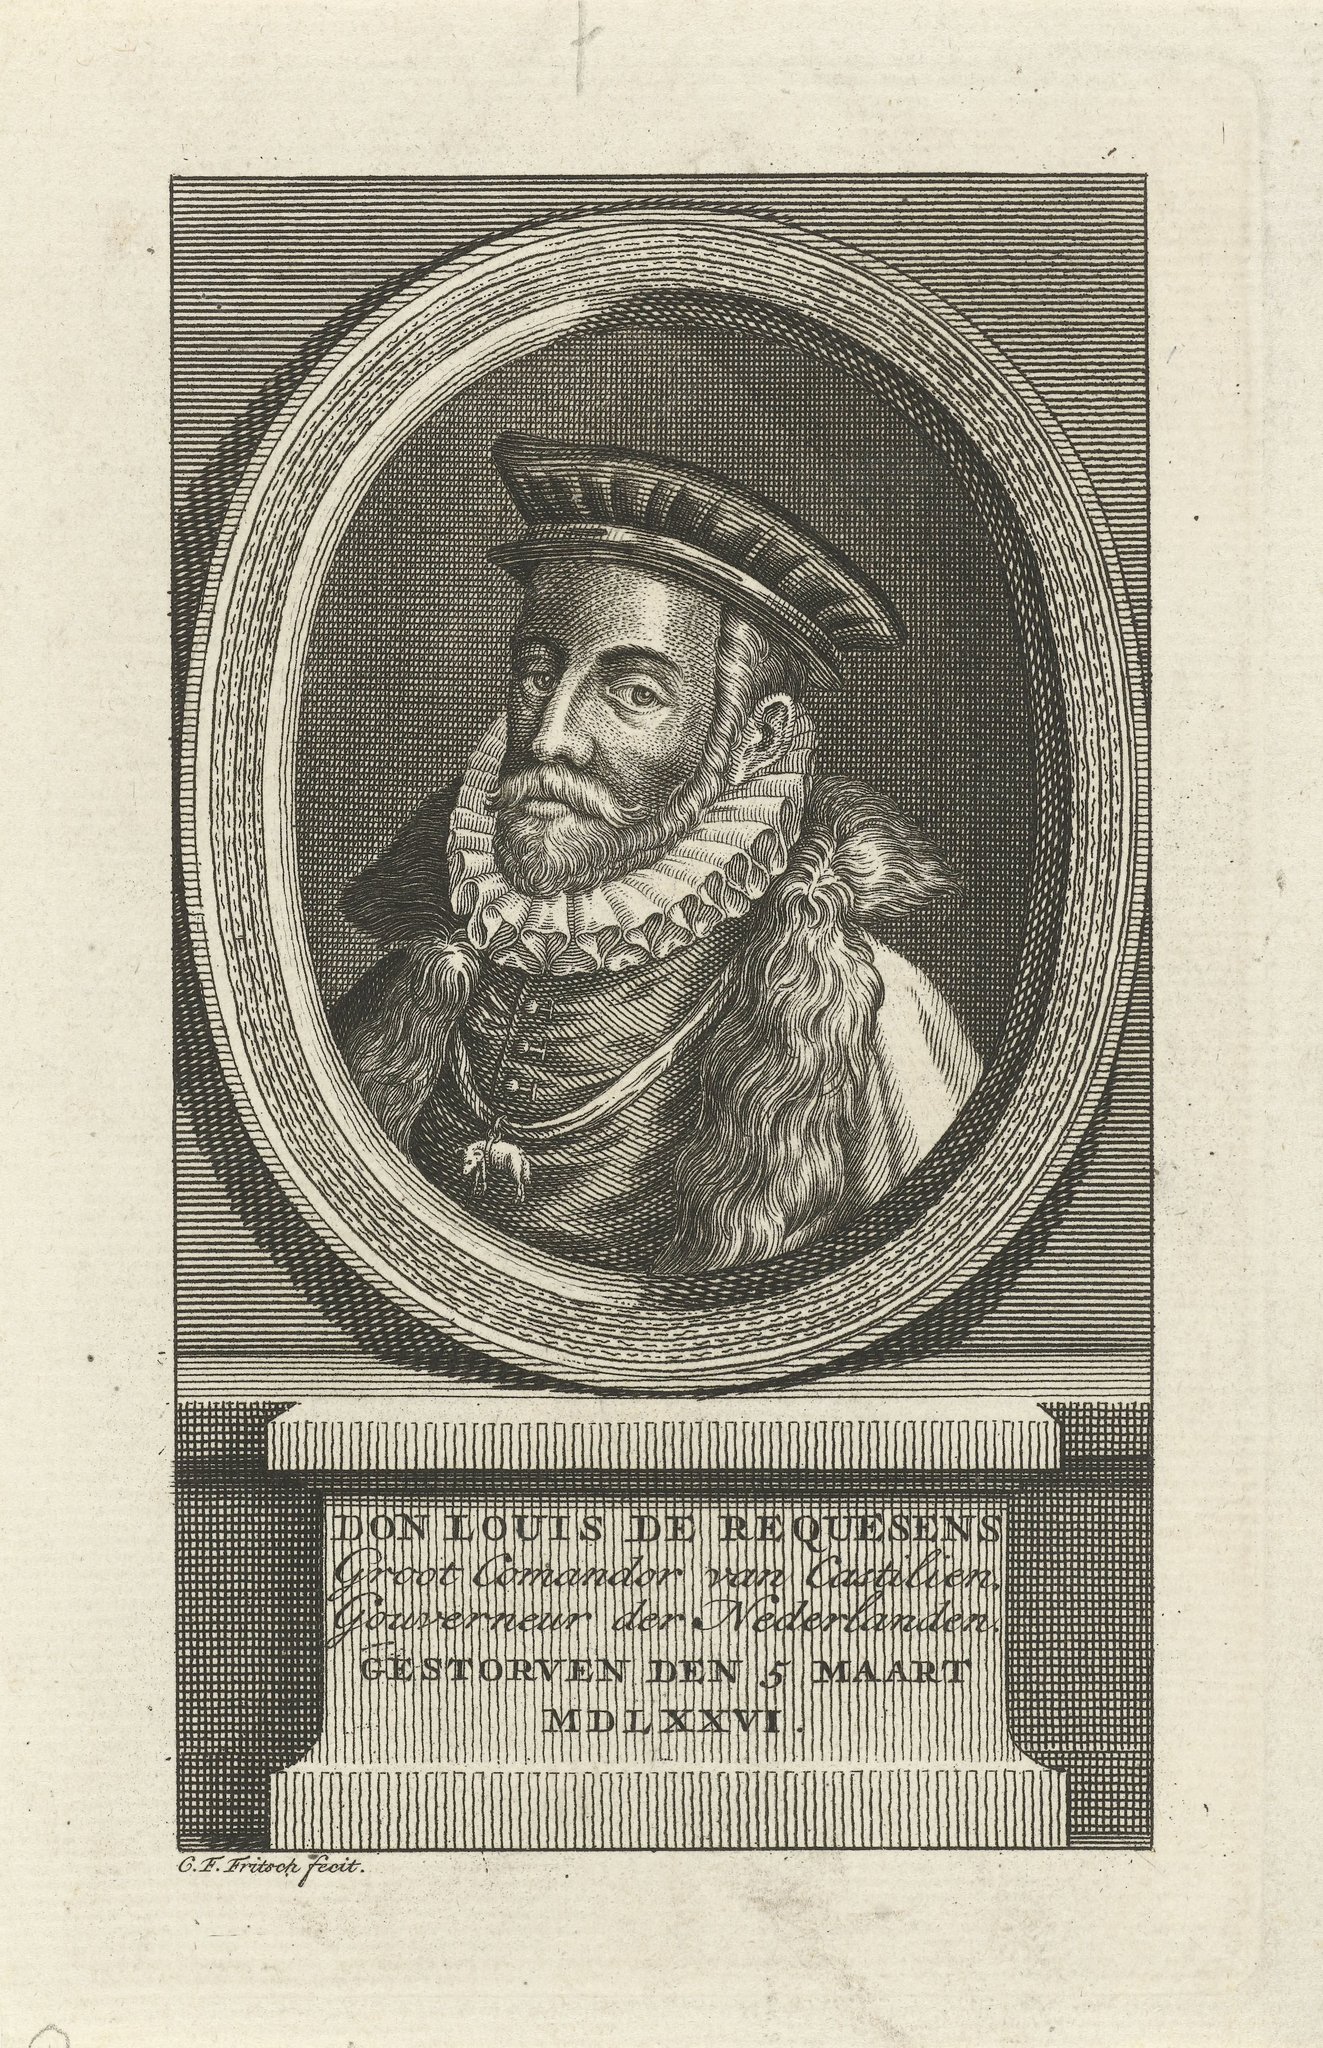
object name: print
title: Portret van Don Luis de Requesens y Zunega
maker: christian friedrich fritzsch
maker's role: print maker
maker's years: 1719-1774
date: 1753-1774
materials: paper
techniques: etching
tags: brussels, mayor, luis de zúñiga y requesens, knighthood order of the golden fleece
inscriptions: collector's mark: Lugt 2228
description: Portret opgenomen in: Meteren, Emanuel van. Historie van de oorlogen en geschiedenissen der Nederlanderen, en der zelver Naburen: beginnende met den Jare 1315, en eindigende met den Jare 1611, deel 2 van 10. Amsterdam: Steven Jacobus Baalde, 1786.